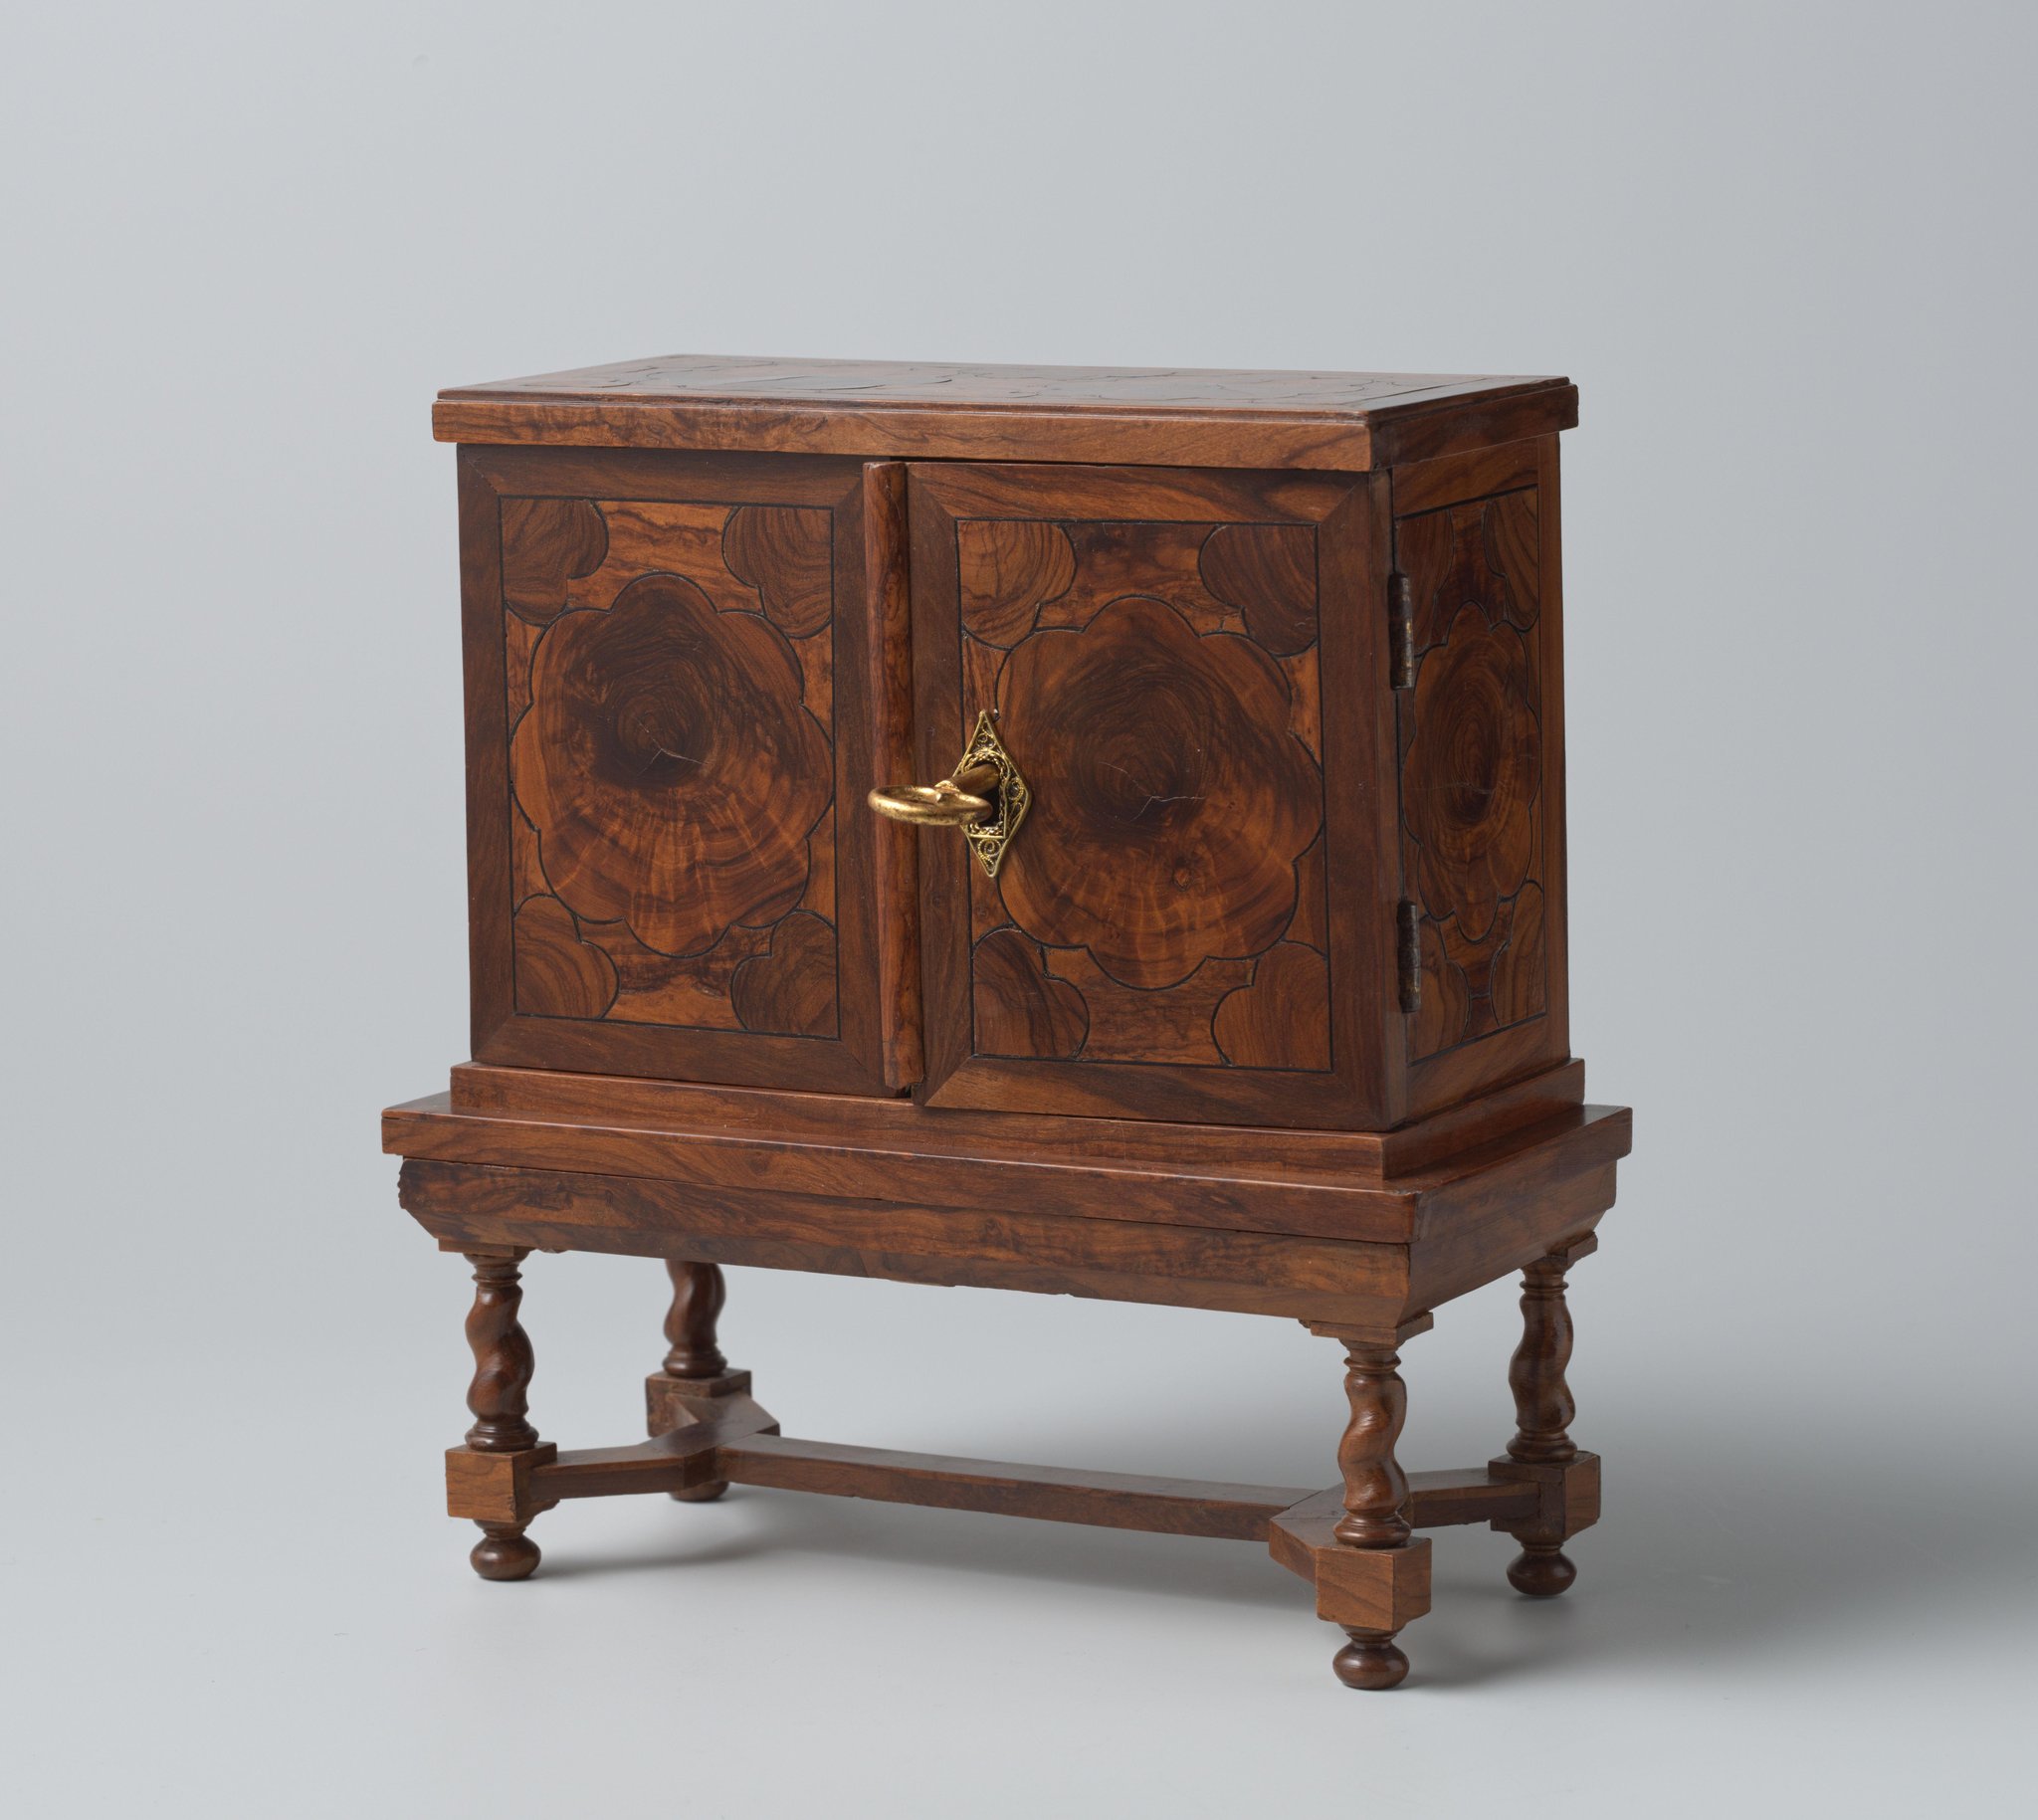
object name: miniature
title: Kabinet, belijmd met olijfhout en ebbenhout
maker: Anonymous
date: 1676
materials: wood, iron, metal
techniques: filigree, gilding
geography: amsterdam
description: Kabinet, belijmd met olijfhout en ebbenhout op een kern van eikenhout en cederhout. Los onderstel met uitschuifbare lade van cederhout, waarvan het voorblad de gehele voorregel van het onderstel vormt. De getorste poten zijn verbonden met een y-vormig kruis en rusten op bolpoten. De rechthoekig, vlakke boekenkast is zowel op de deuren aan buiten en binnenzijde, als op de bovenkant gefineerd met een geometrisch patroon van rozetten . De grote vergulde scharnieren zijn onder het fineer vastgemaakt. De deuren kunnen gesloten worden met een ijzeren schuifslot en een draaislot met een slotplaat van filigrein goud en een vergulde sleutel. In de kast zijn één halfdiepe en twee diepe planken aangebracht.